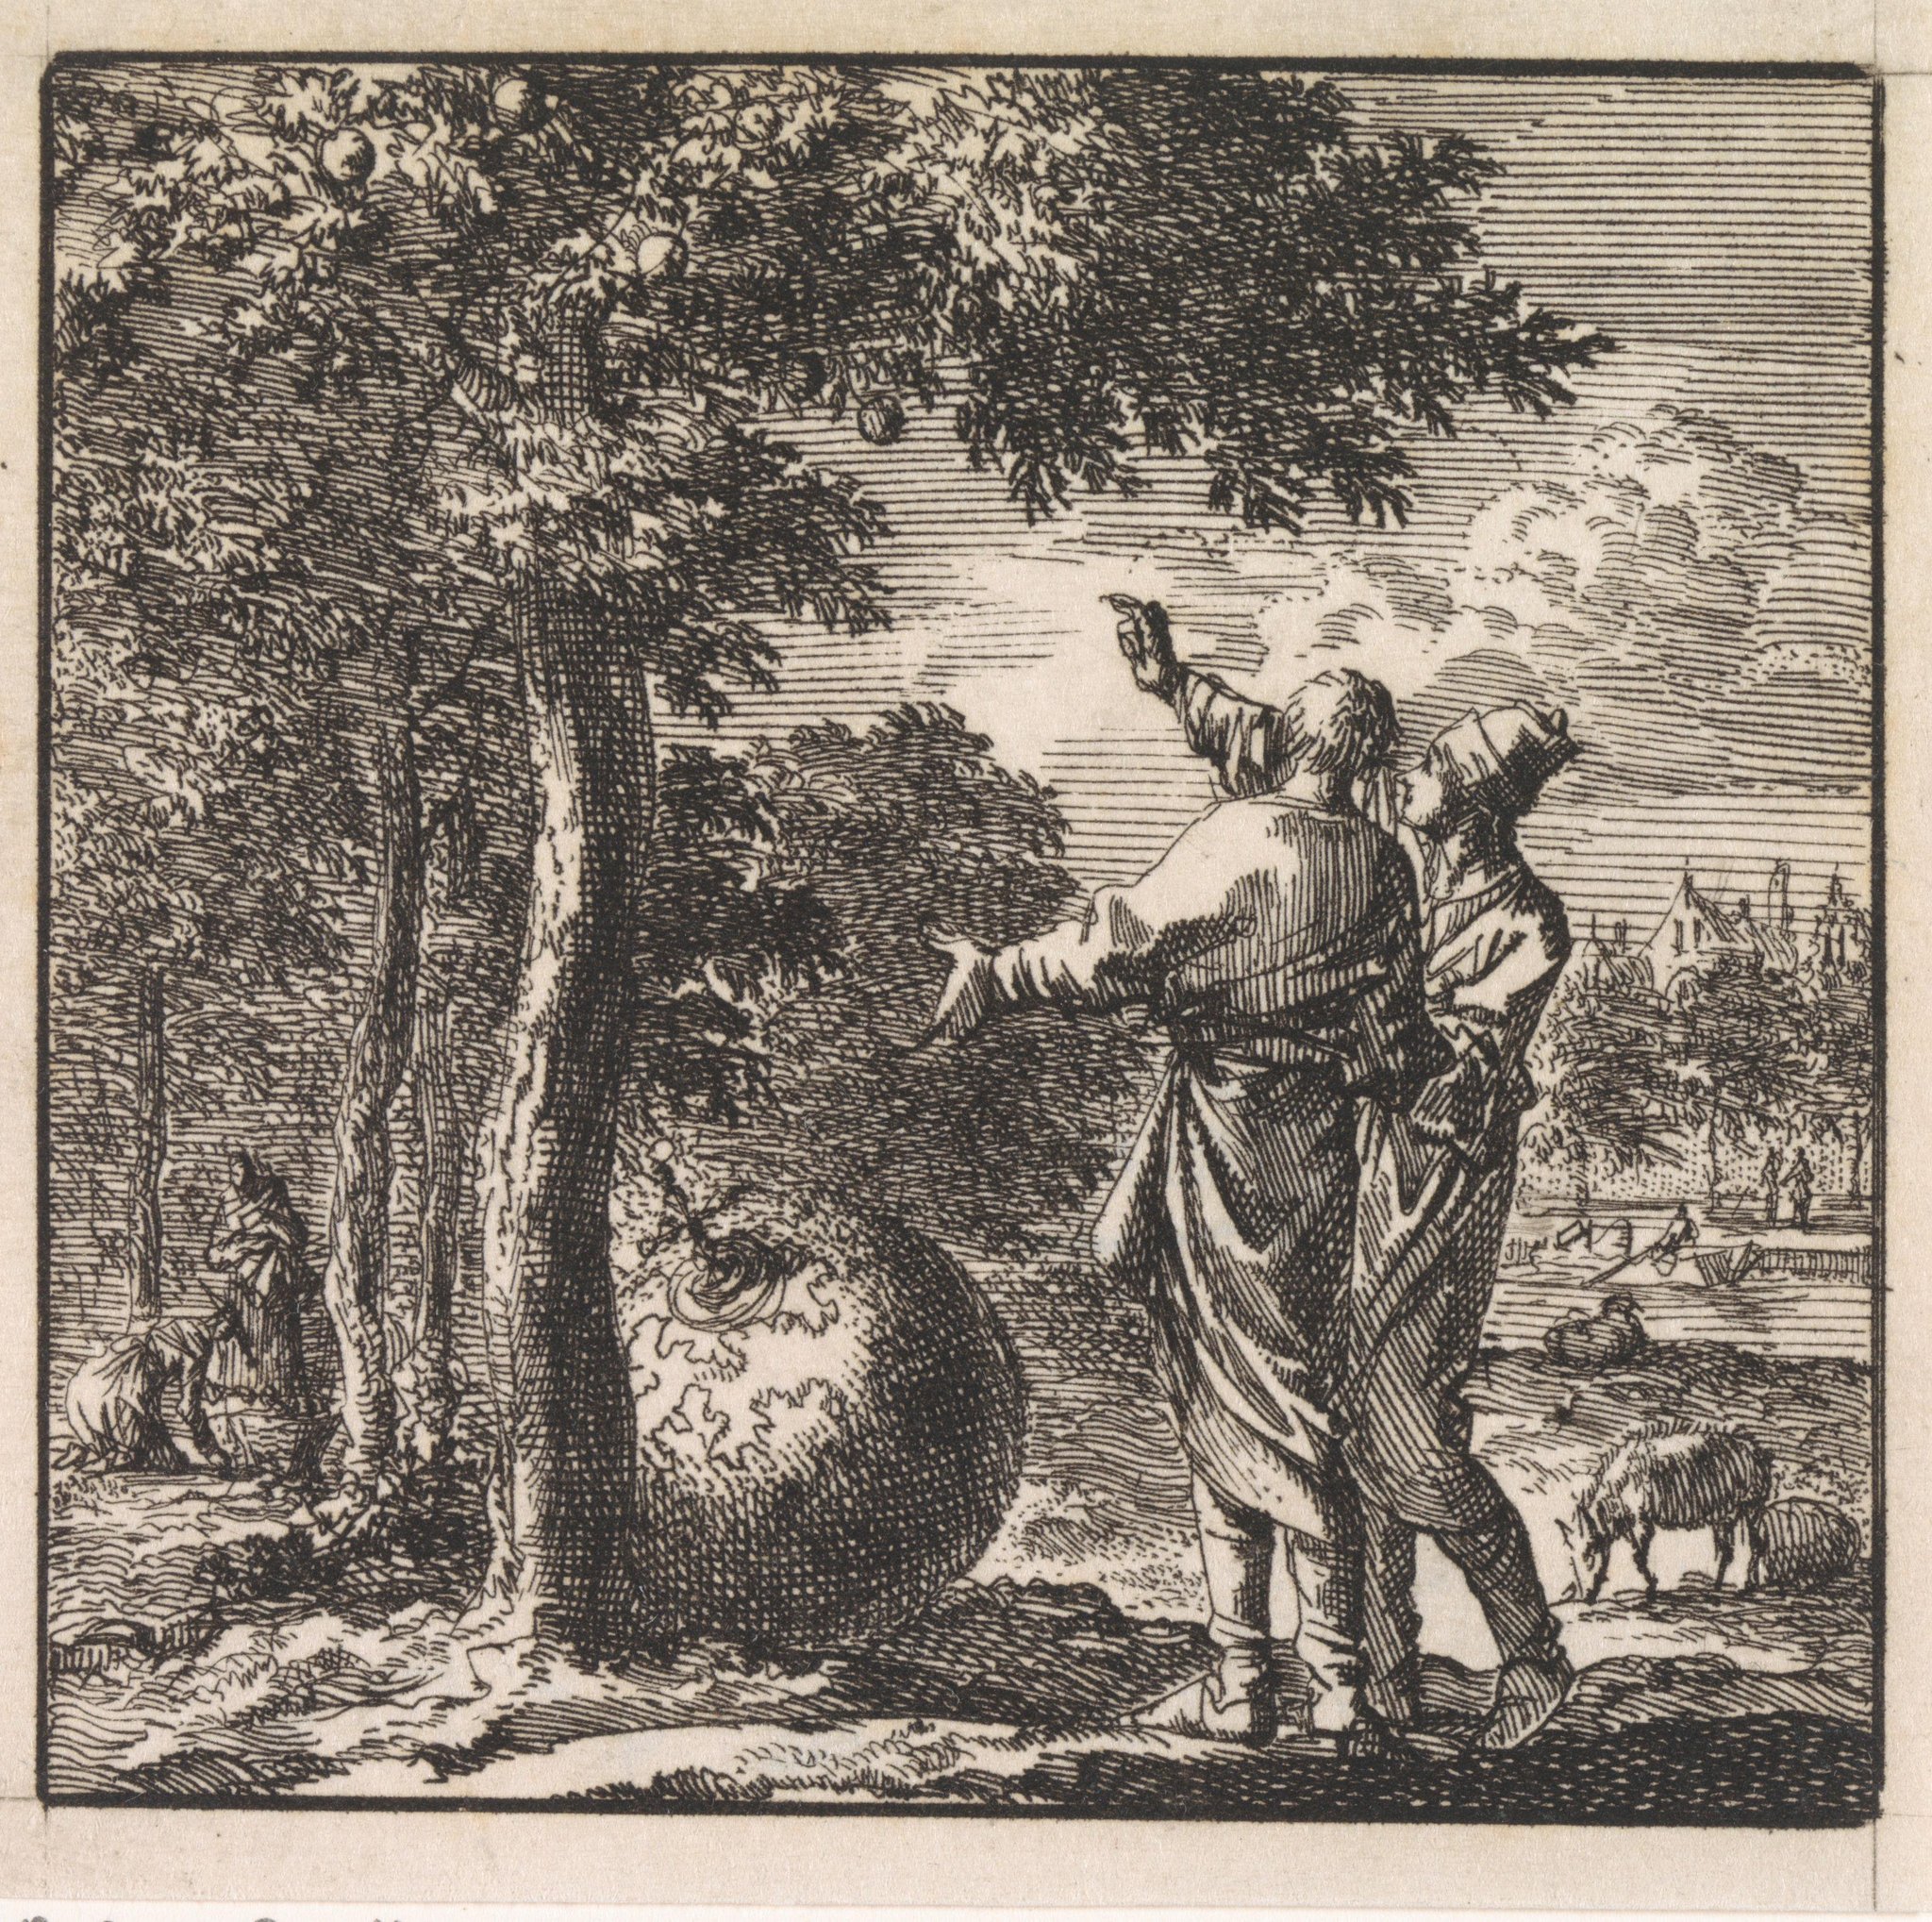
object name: print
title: Het besten, is het minst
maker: jan luyken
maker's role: draughtsman, print maker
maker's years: 1649-1712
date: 1710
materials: paper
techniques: etching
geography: amsterdam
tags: earth, world as celestial body, trees, conversation, dialogue; conversation piece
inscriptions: collector's mark: Lugt 2228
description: Proefdruk voor illustratie uit: Luyken, Jan. De onwaardige wereld, vertoond in vyftig zinnebeelden, met godlyke spreuken en stichtelyke verzen. Amsterdam: Pieter Arentsz. II (wed.) en Cornelis van der Sys, 1710, p. 152.